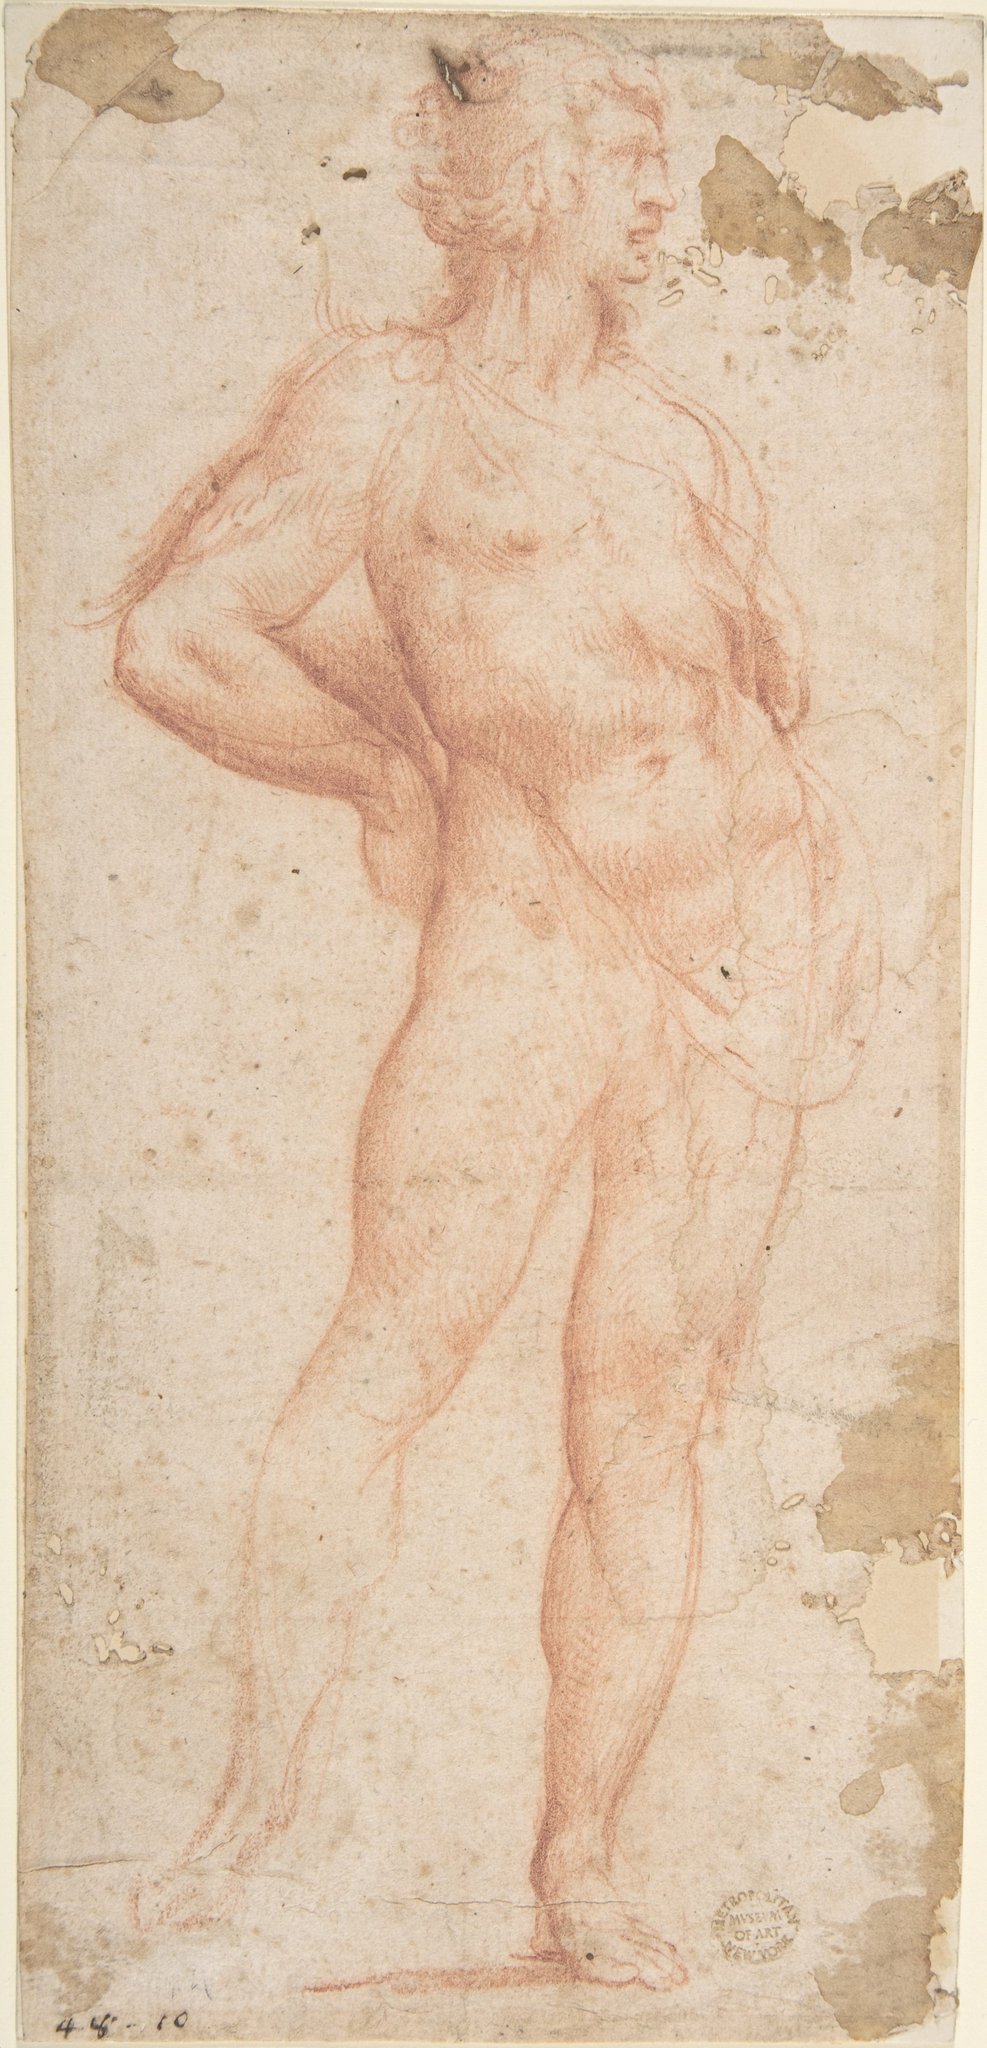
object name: drawing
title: Standing Nude Man (Bacchus)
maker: cavaliere d'arpino (giuseppe cesari)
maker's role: artist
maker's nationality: italian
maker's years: 1568-1640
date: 1590-1600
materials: chalk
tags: male nudes